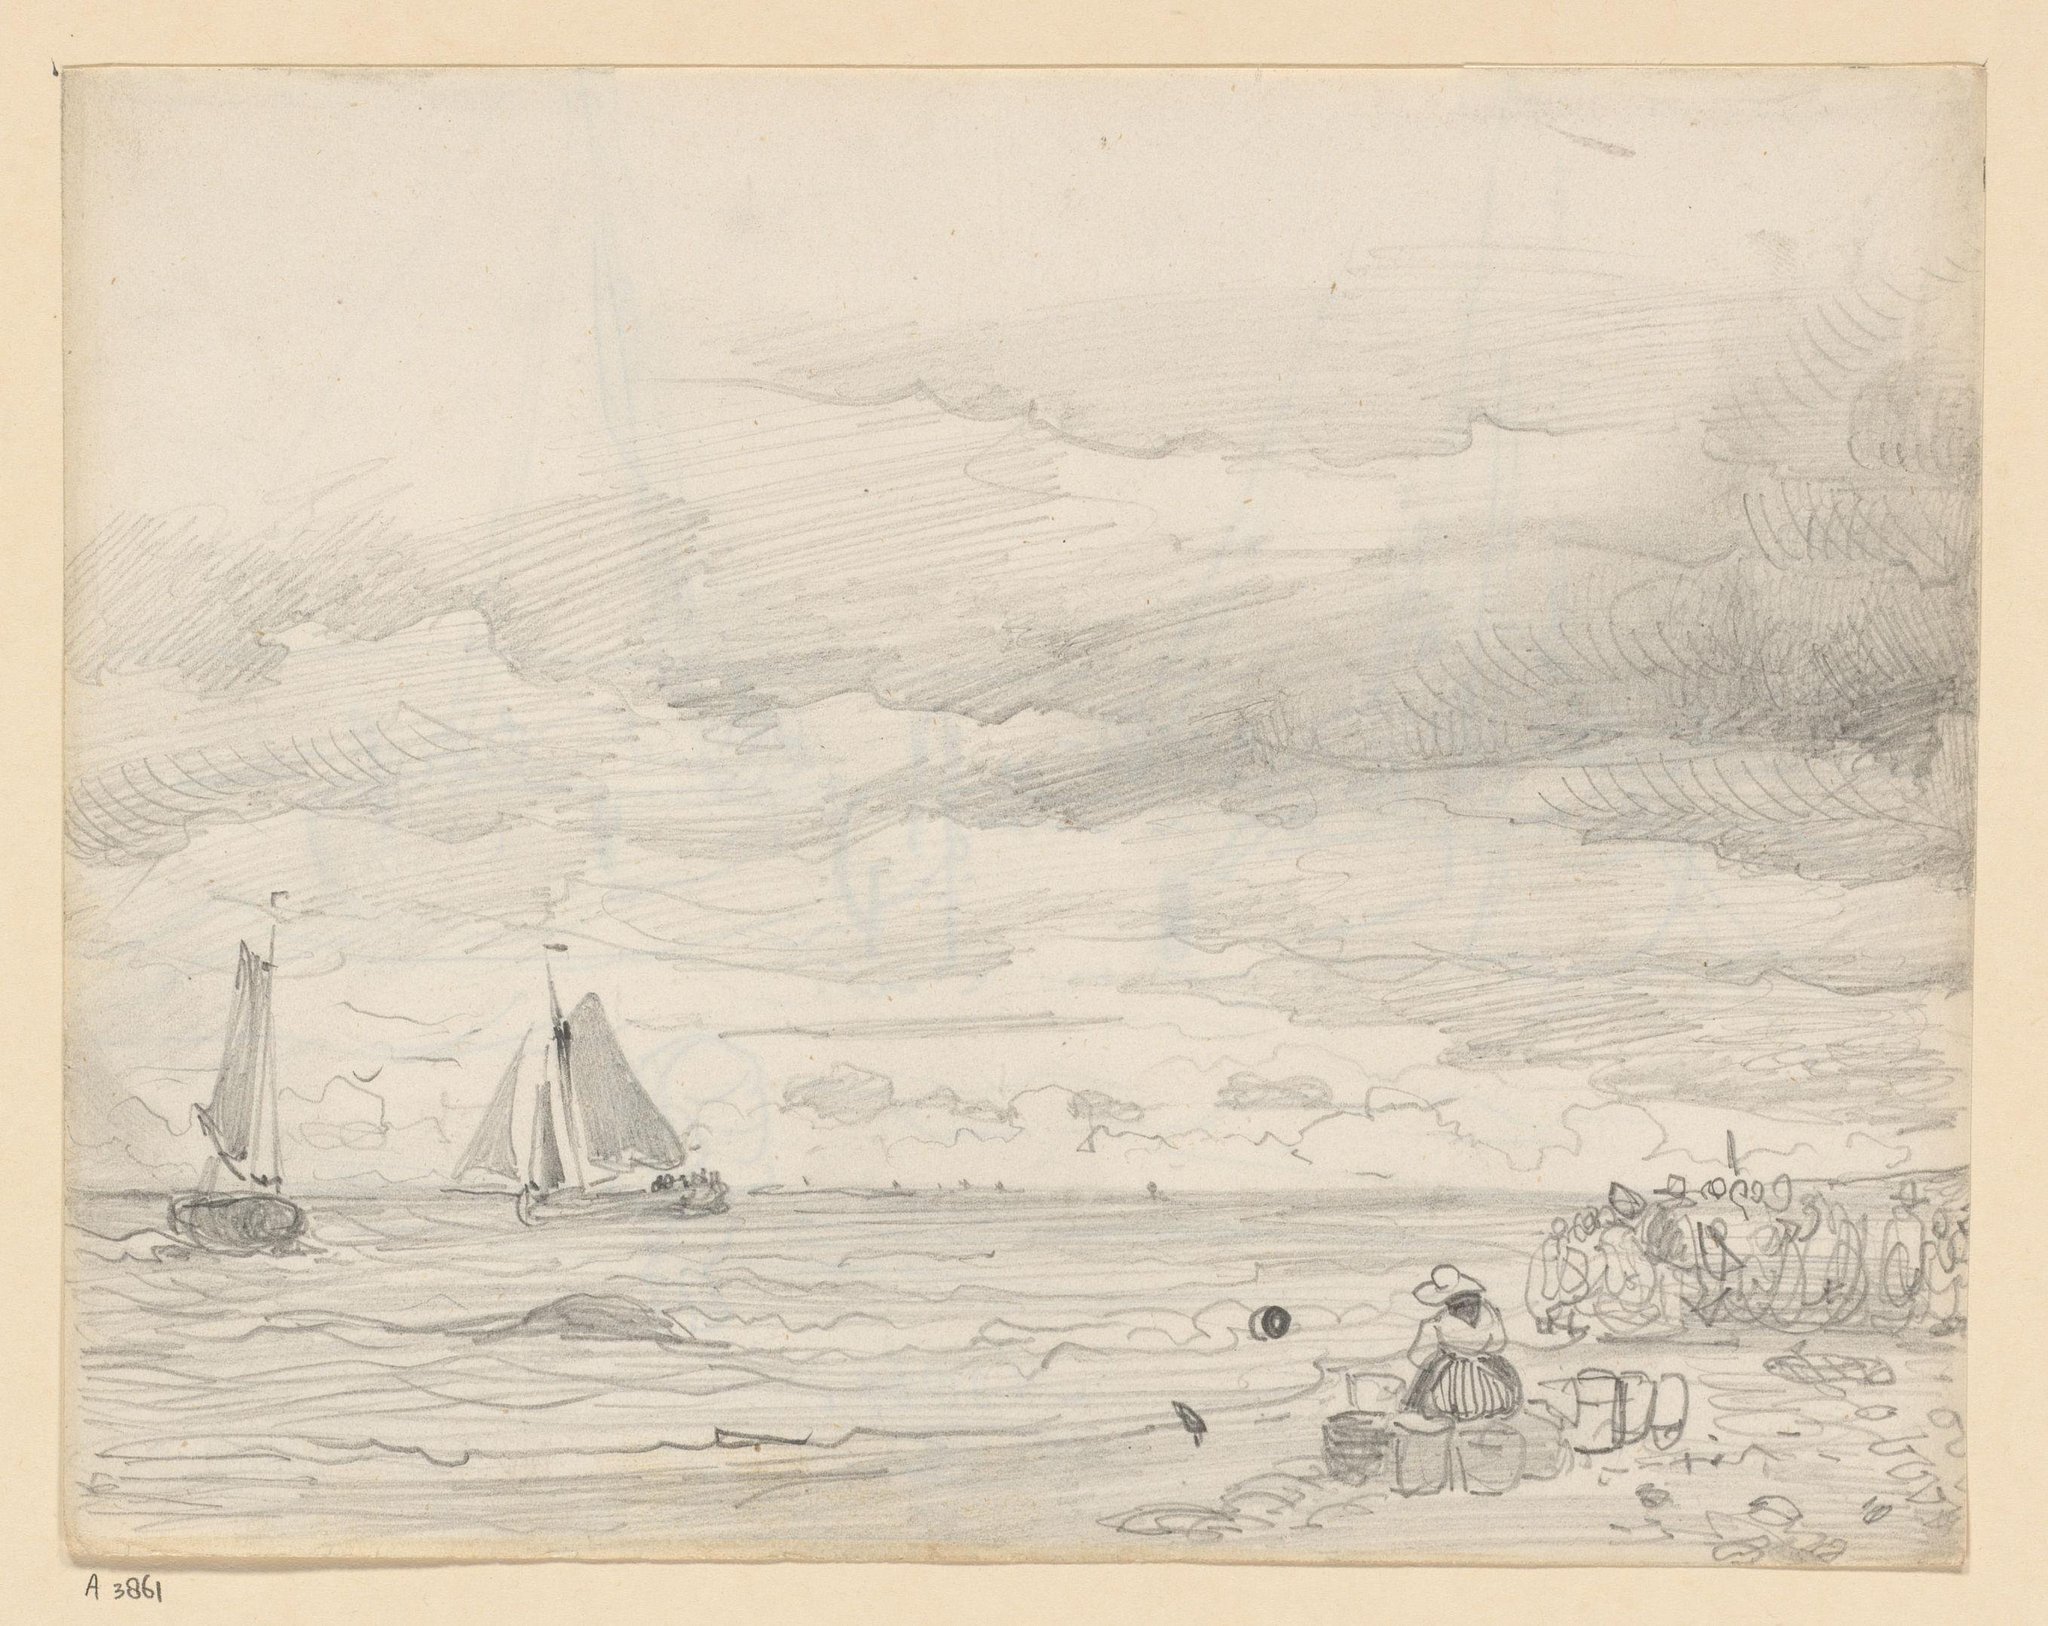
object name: drawing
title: Figuren op het strand, wachtend op de aankomst van de vissersboten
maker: willem anthonie van deventer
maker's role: draughtsman, painter, print maker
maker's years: 1824-1893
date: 1834-1893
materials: paper, pencil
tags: sailing-ship, sailing-boat, beach